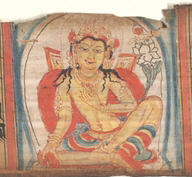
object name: folio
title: The Bodhisattva Avalokiteshvara, Folio from a dispersed Ashtasahasrika Prajnapramita (Perfection of Wisdom) Manuscript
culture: indian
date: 1101-1200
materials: ink, leaf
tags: lotuses,buddhism,avalokiteshvara,bodhisattvas